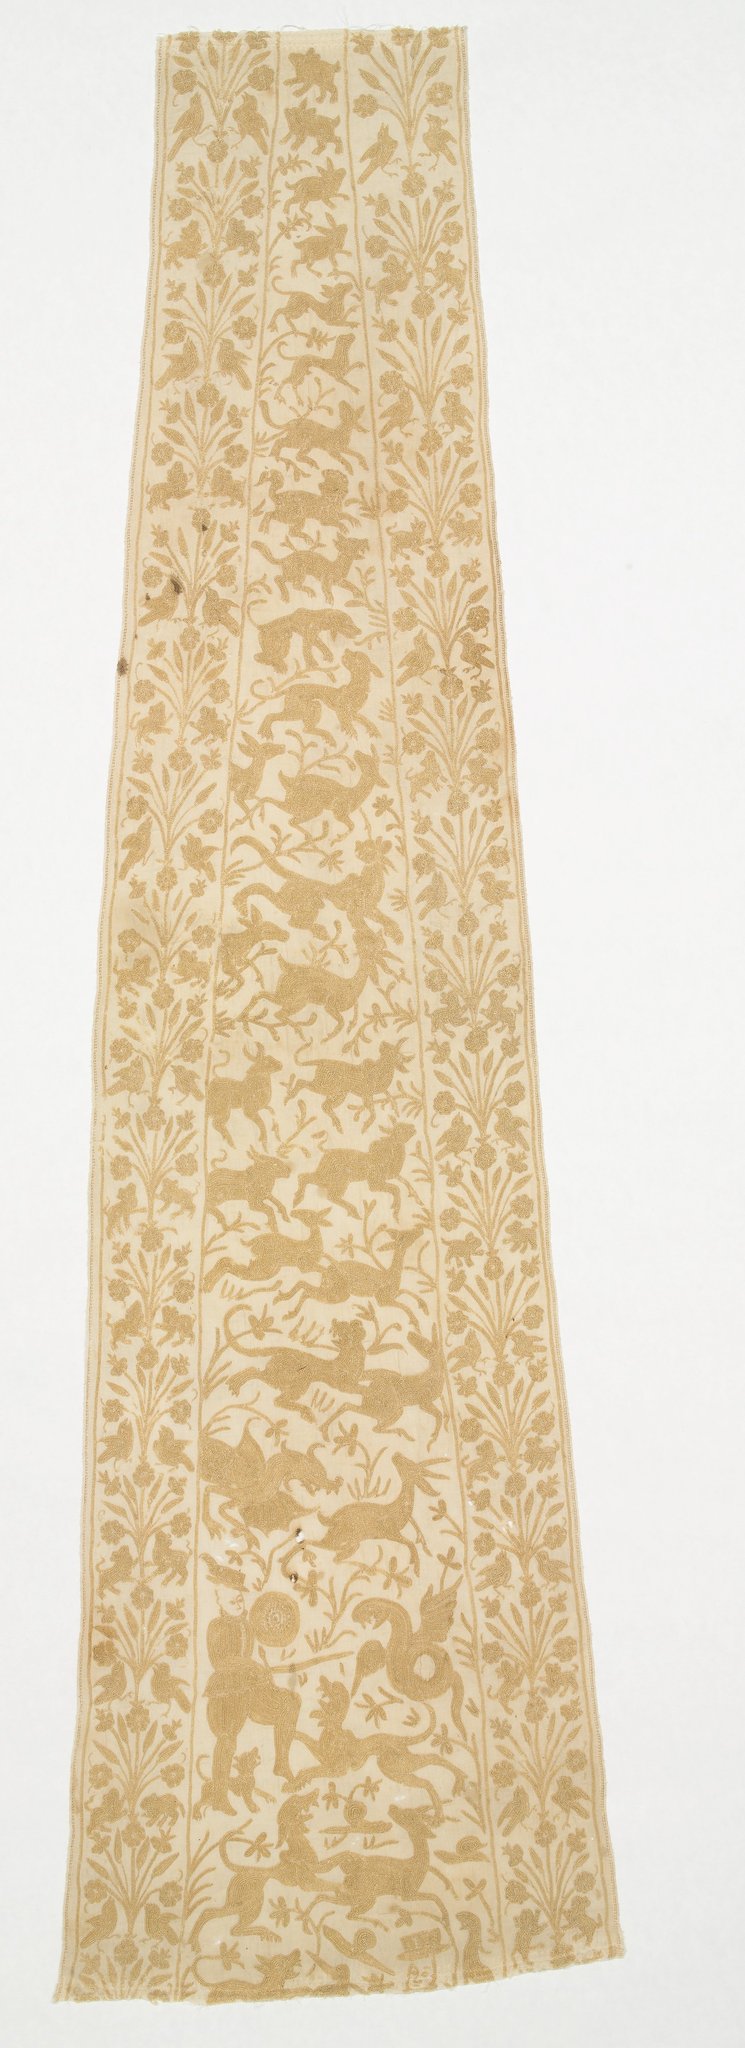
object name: panel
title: Panel from a Mantle or Apron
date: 1601-1633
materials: cotton, silk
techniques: embroidery, weave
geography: india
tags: animals,men,horses